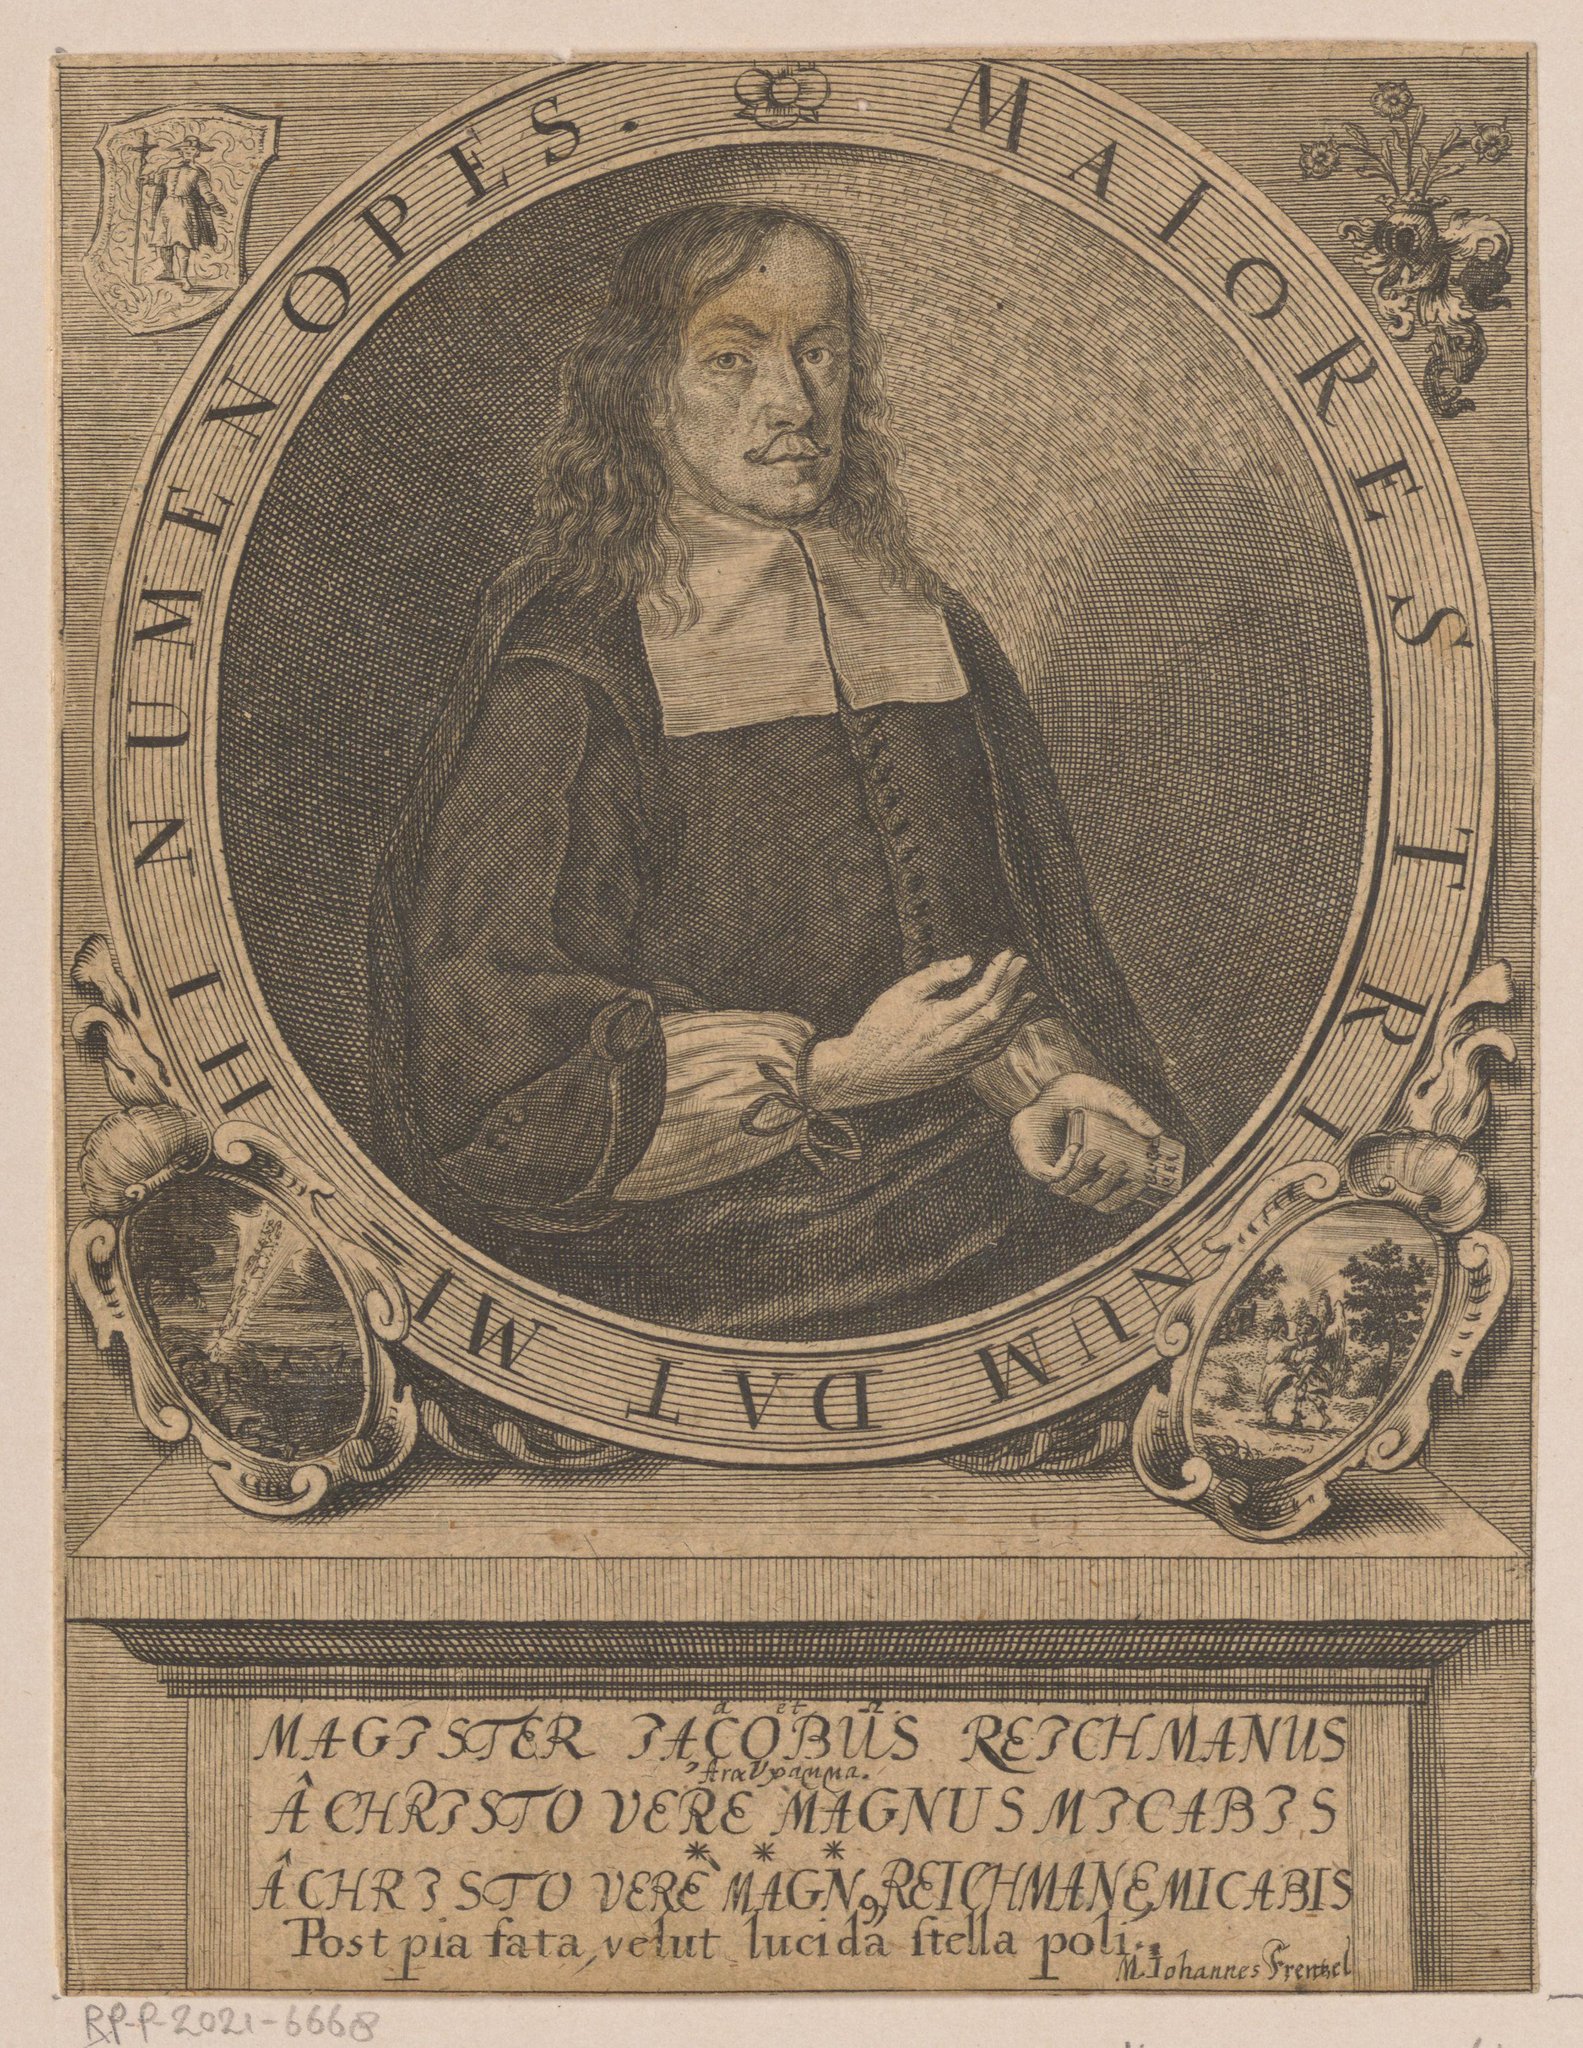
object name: print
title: Portret van Jacob Reichmann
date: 1659-1711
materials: paper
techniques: engraving, etching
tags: historical persons